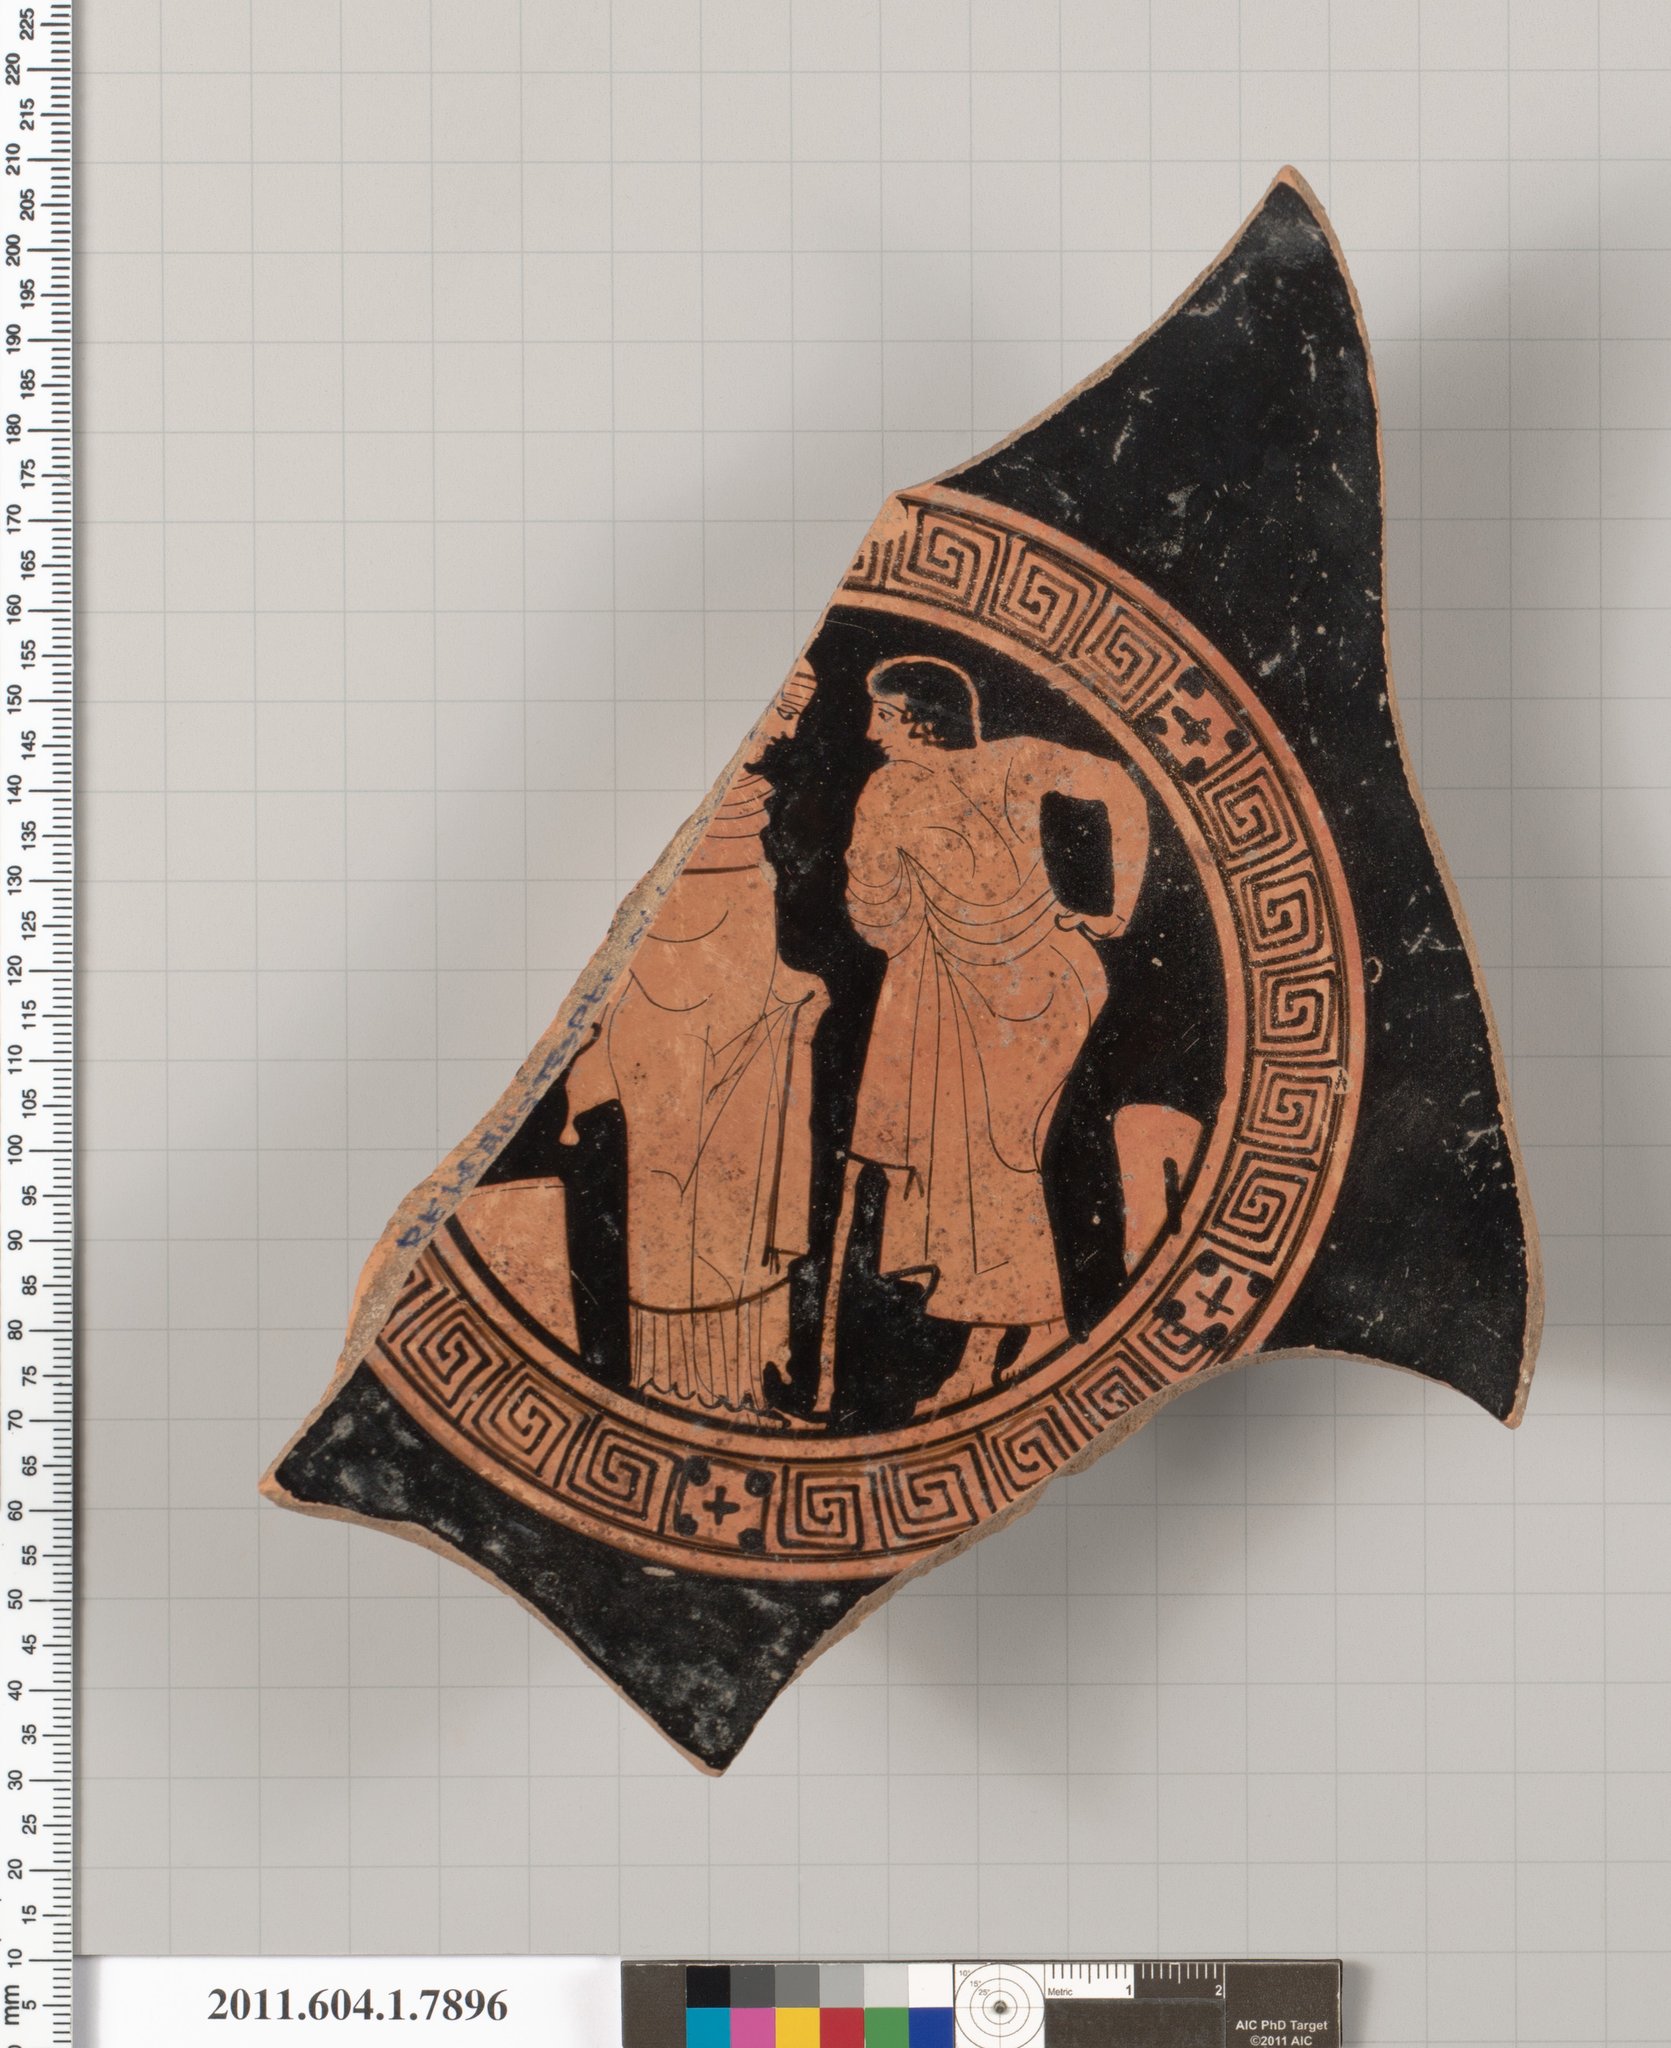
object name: kylix fragment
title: Terracotta fragment of a kylix (drinking cup)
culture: greek, attic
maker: painter of london e 777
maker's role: artist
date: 450 BCE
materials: terracotta